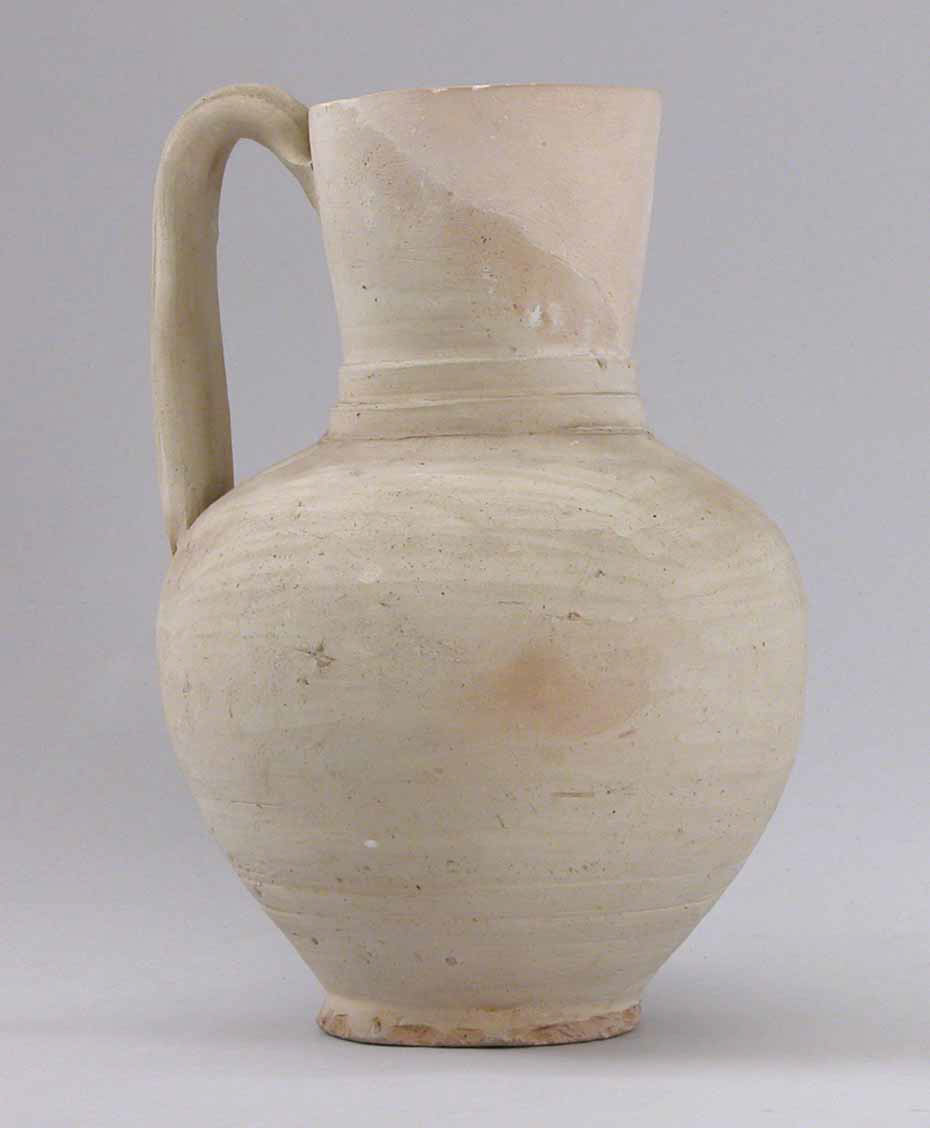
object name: ewer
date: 767-900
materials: earthenware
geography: iran